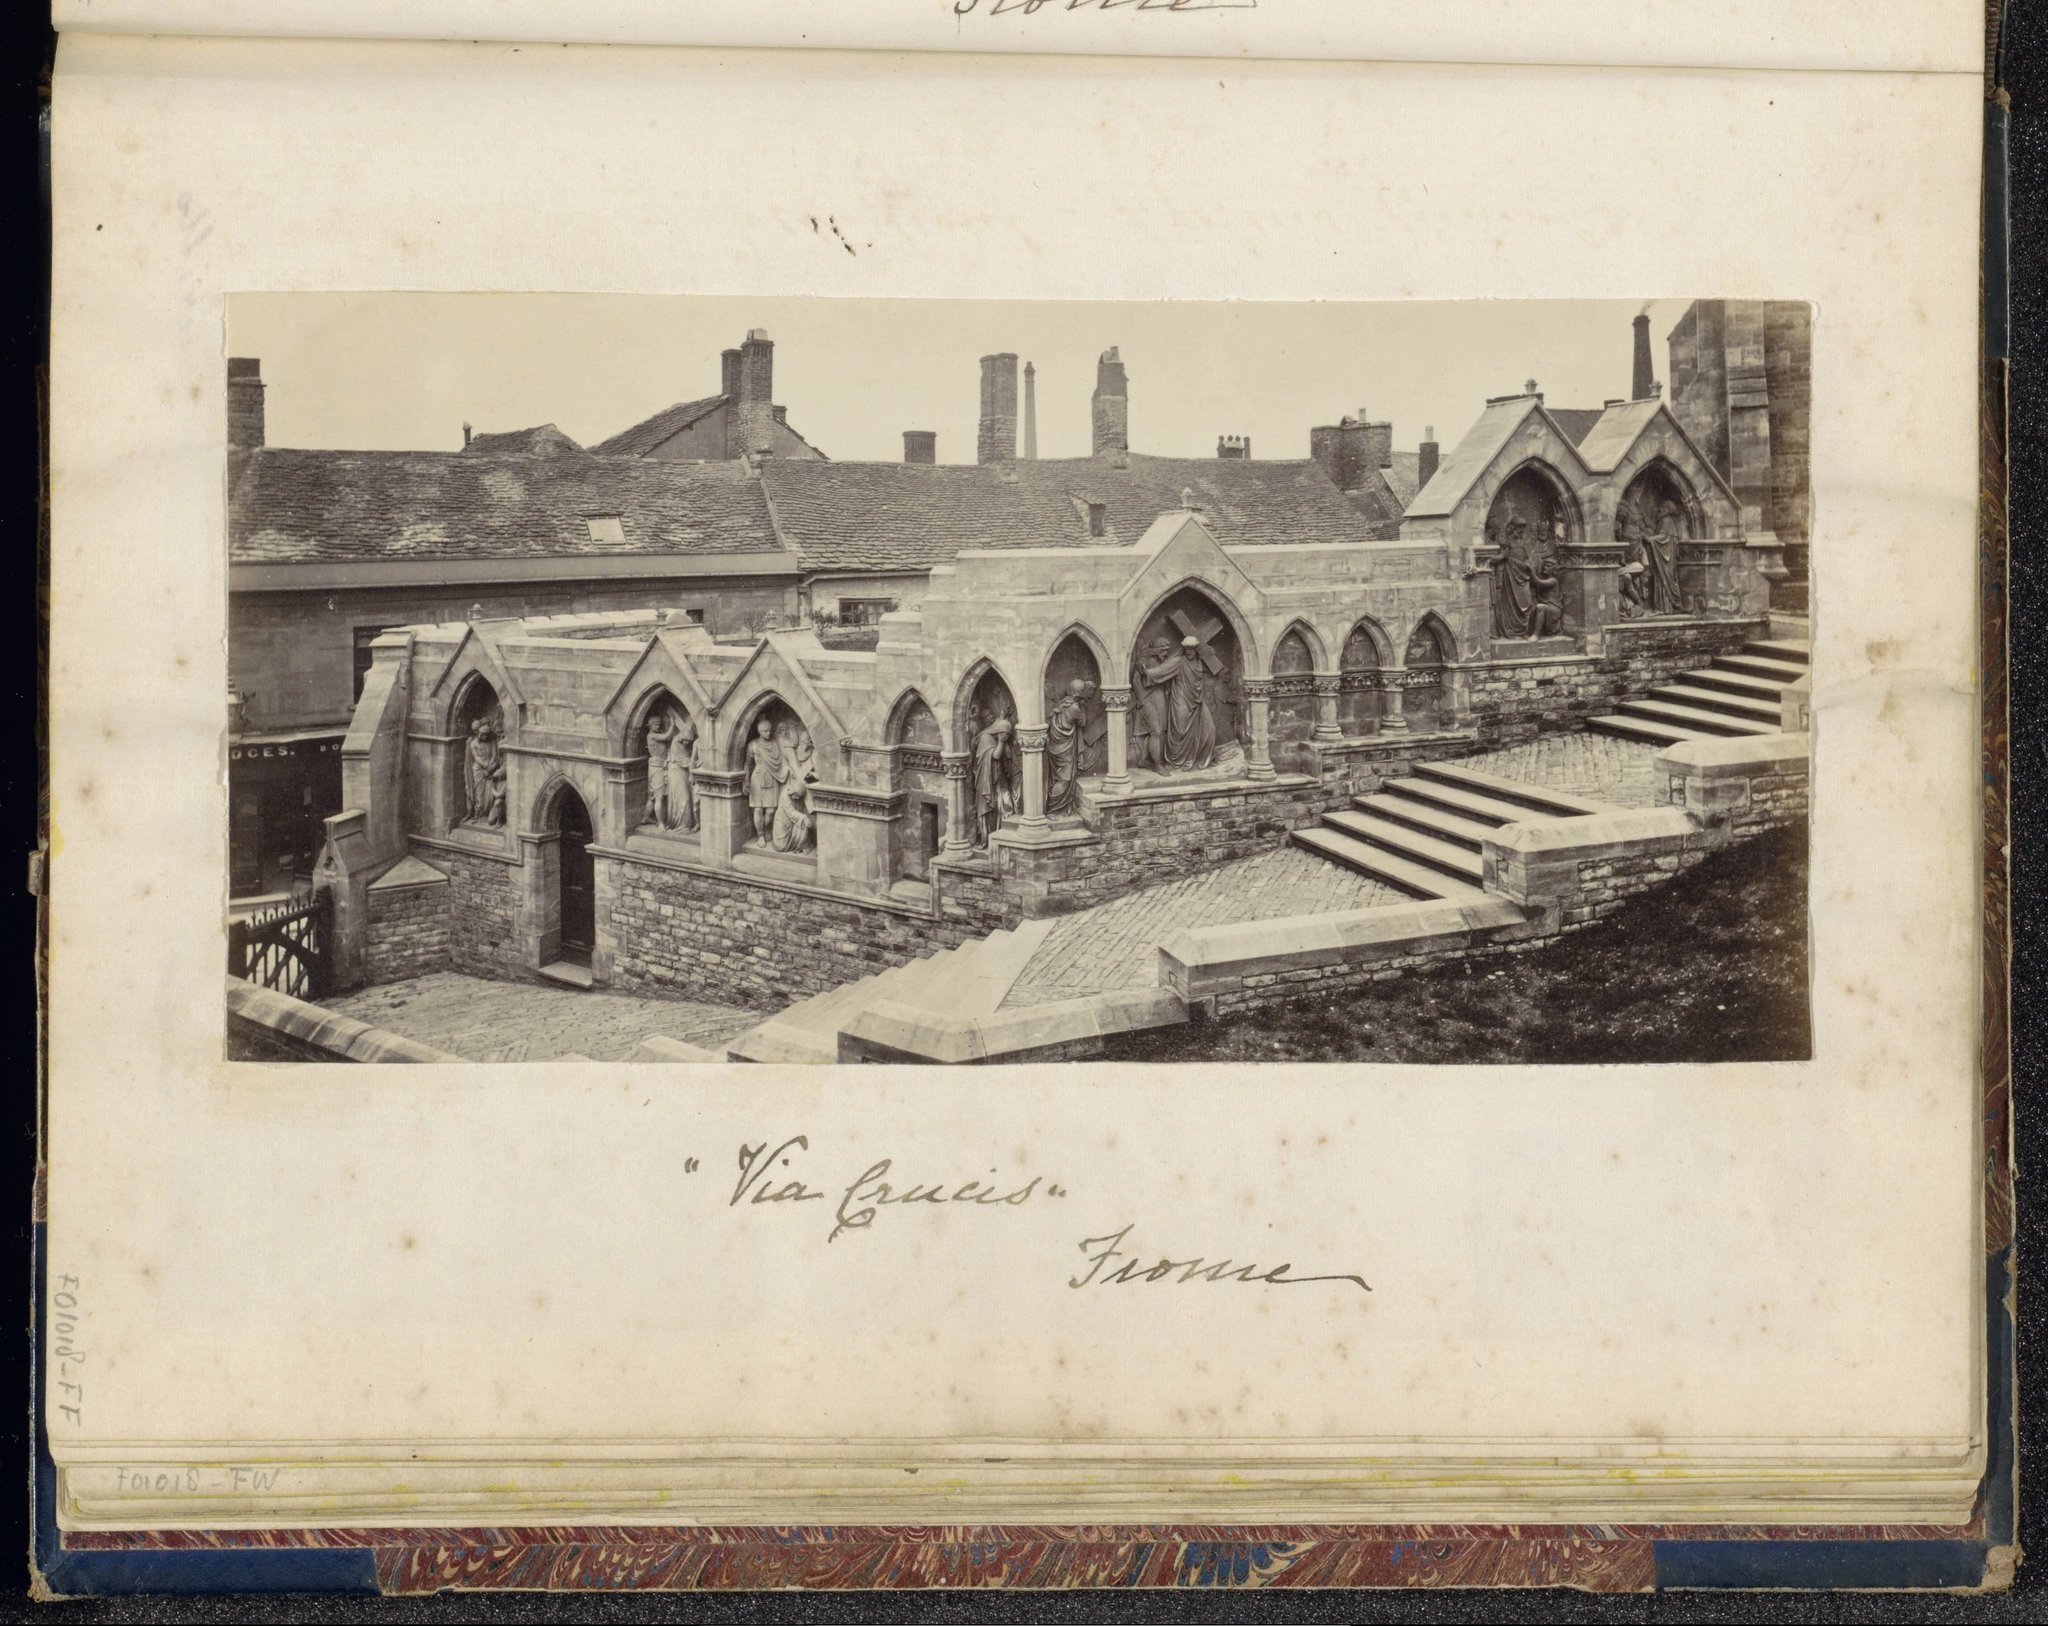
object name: photograph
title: Kruisweg bij de Johannes de Doperkerk in Frome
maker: Anonymous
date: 1860-1870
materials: paper, photographic support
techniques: albumen print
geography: frome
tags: stations of the cross, monument, statue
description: Onderdeel van Engels familiealbum met foto's van personen, reizen, cricket en kunstwerken.